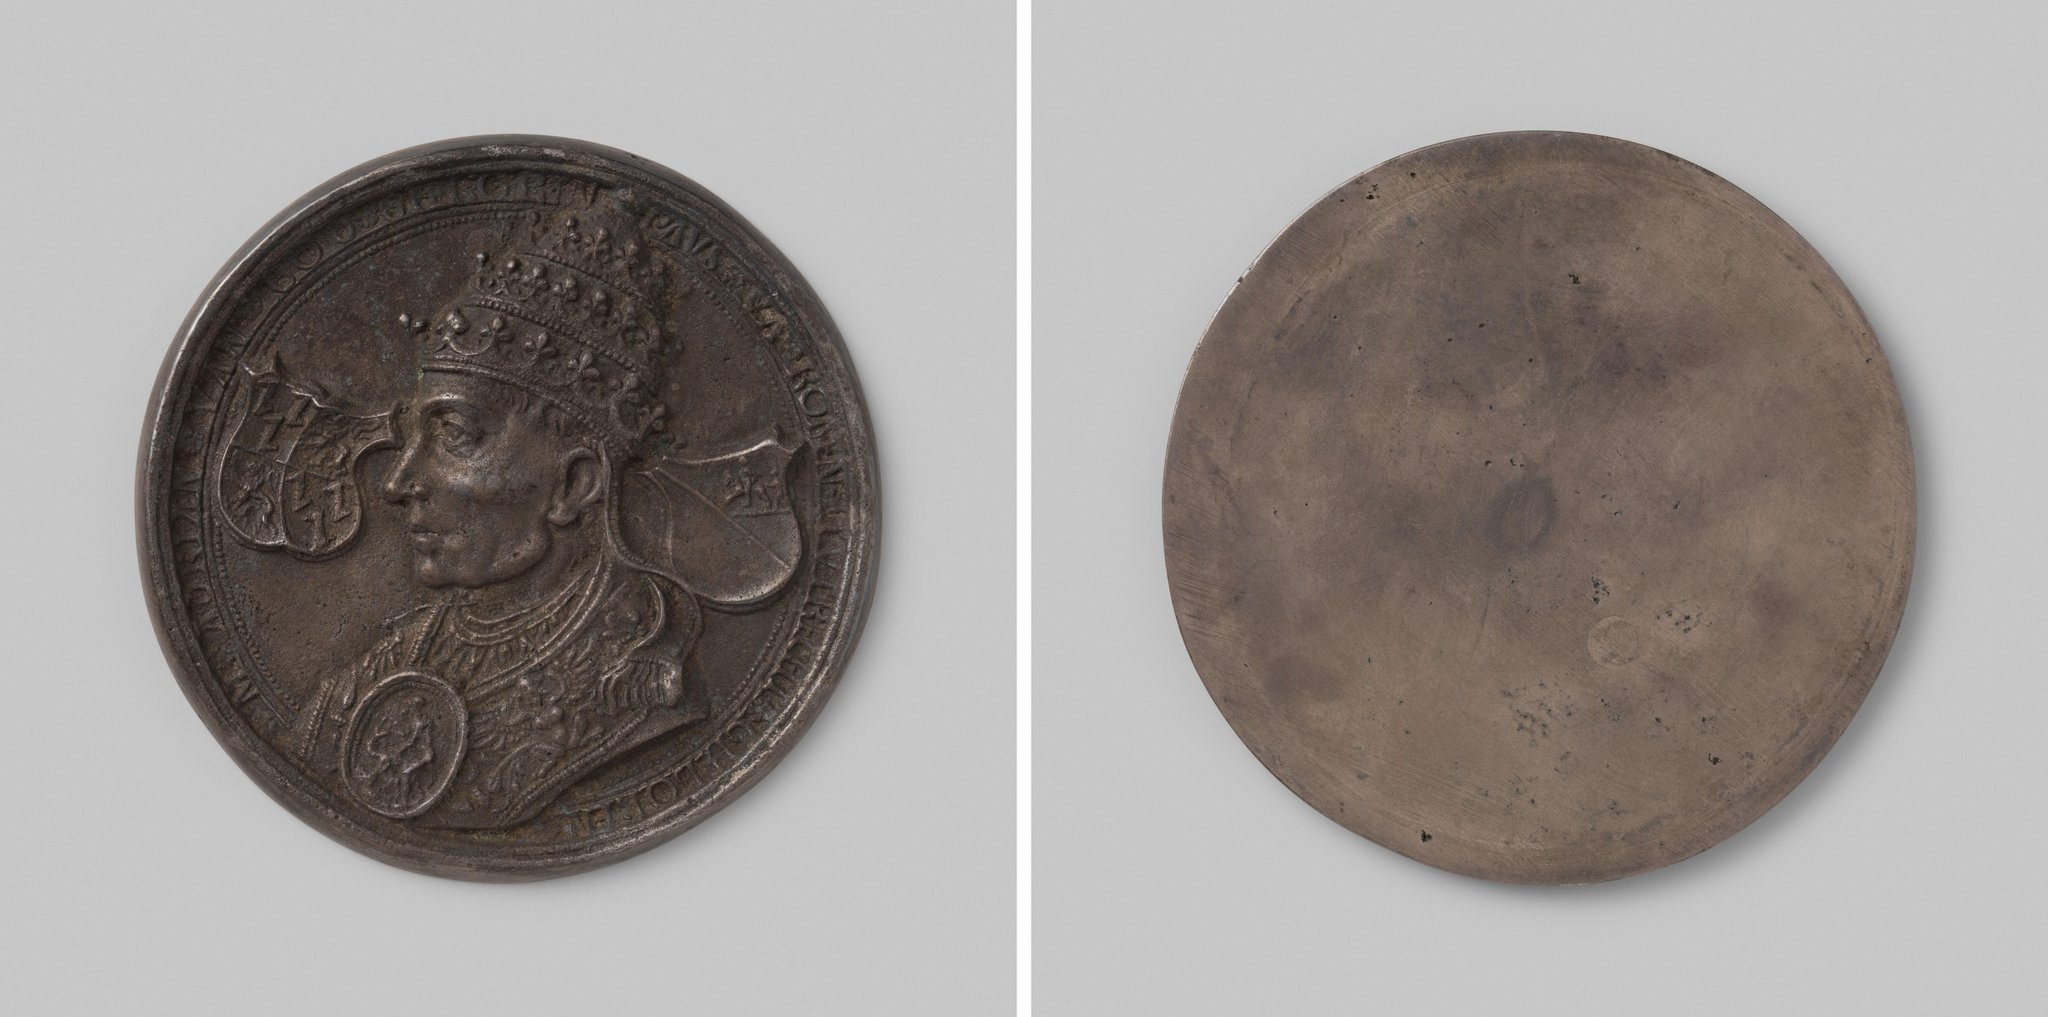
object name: copy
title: Verkiezing van paus Adrianus VI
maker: Anonymous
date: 1522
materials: silver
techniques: striking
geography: netherlands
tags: utrecht, clergyman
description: Eenzijdige zilveren penning. Voorzijde: borststuk man met tiara tussen twee wapenschilden binnen omschrift. Keerzijde: blanco.